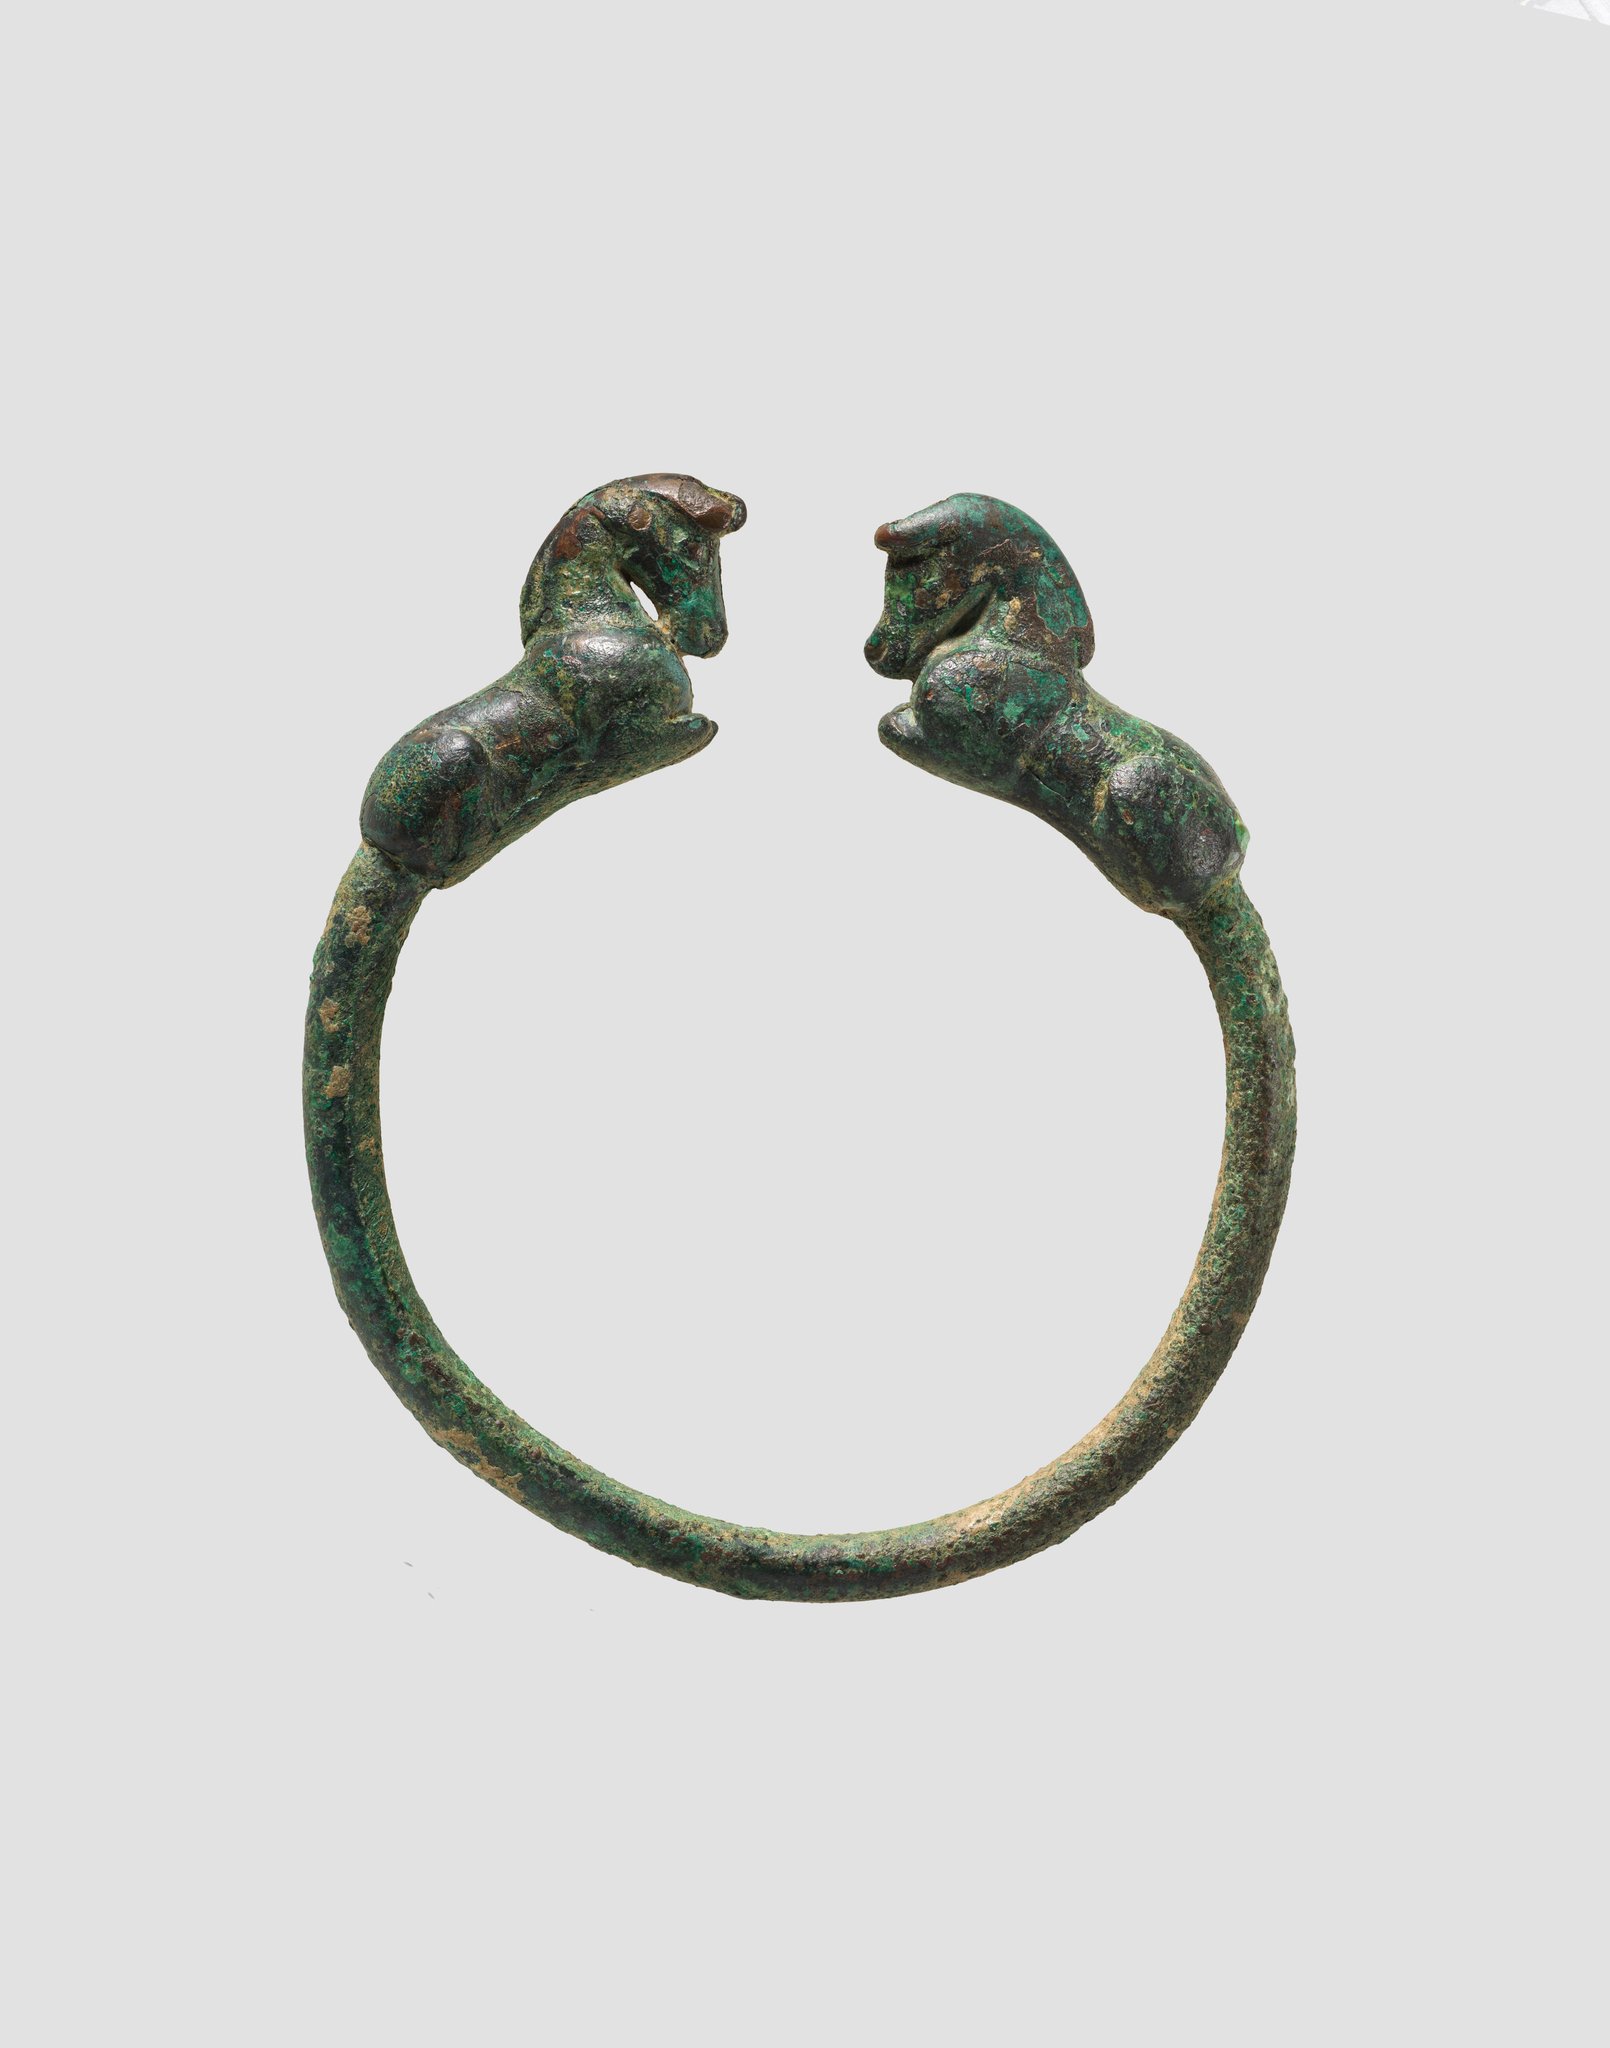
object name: bracelet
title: Bracelet with horses at terminals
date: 1000-1 BCE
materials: bronze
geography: western iran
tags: horses